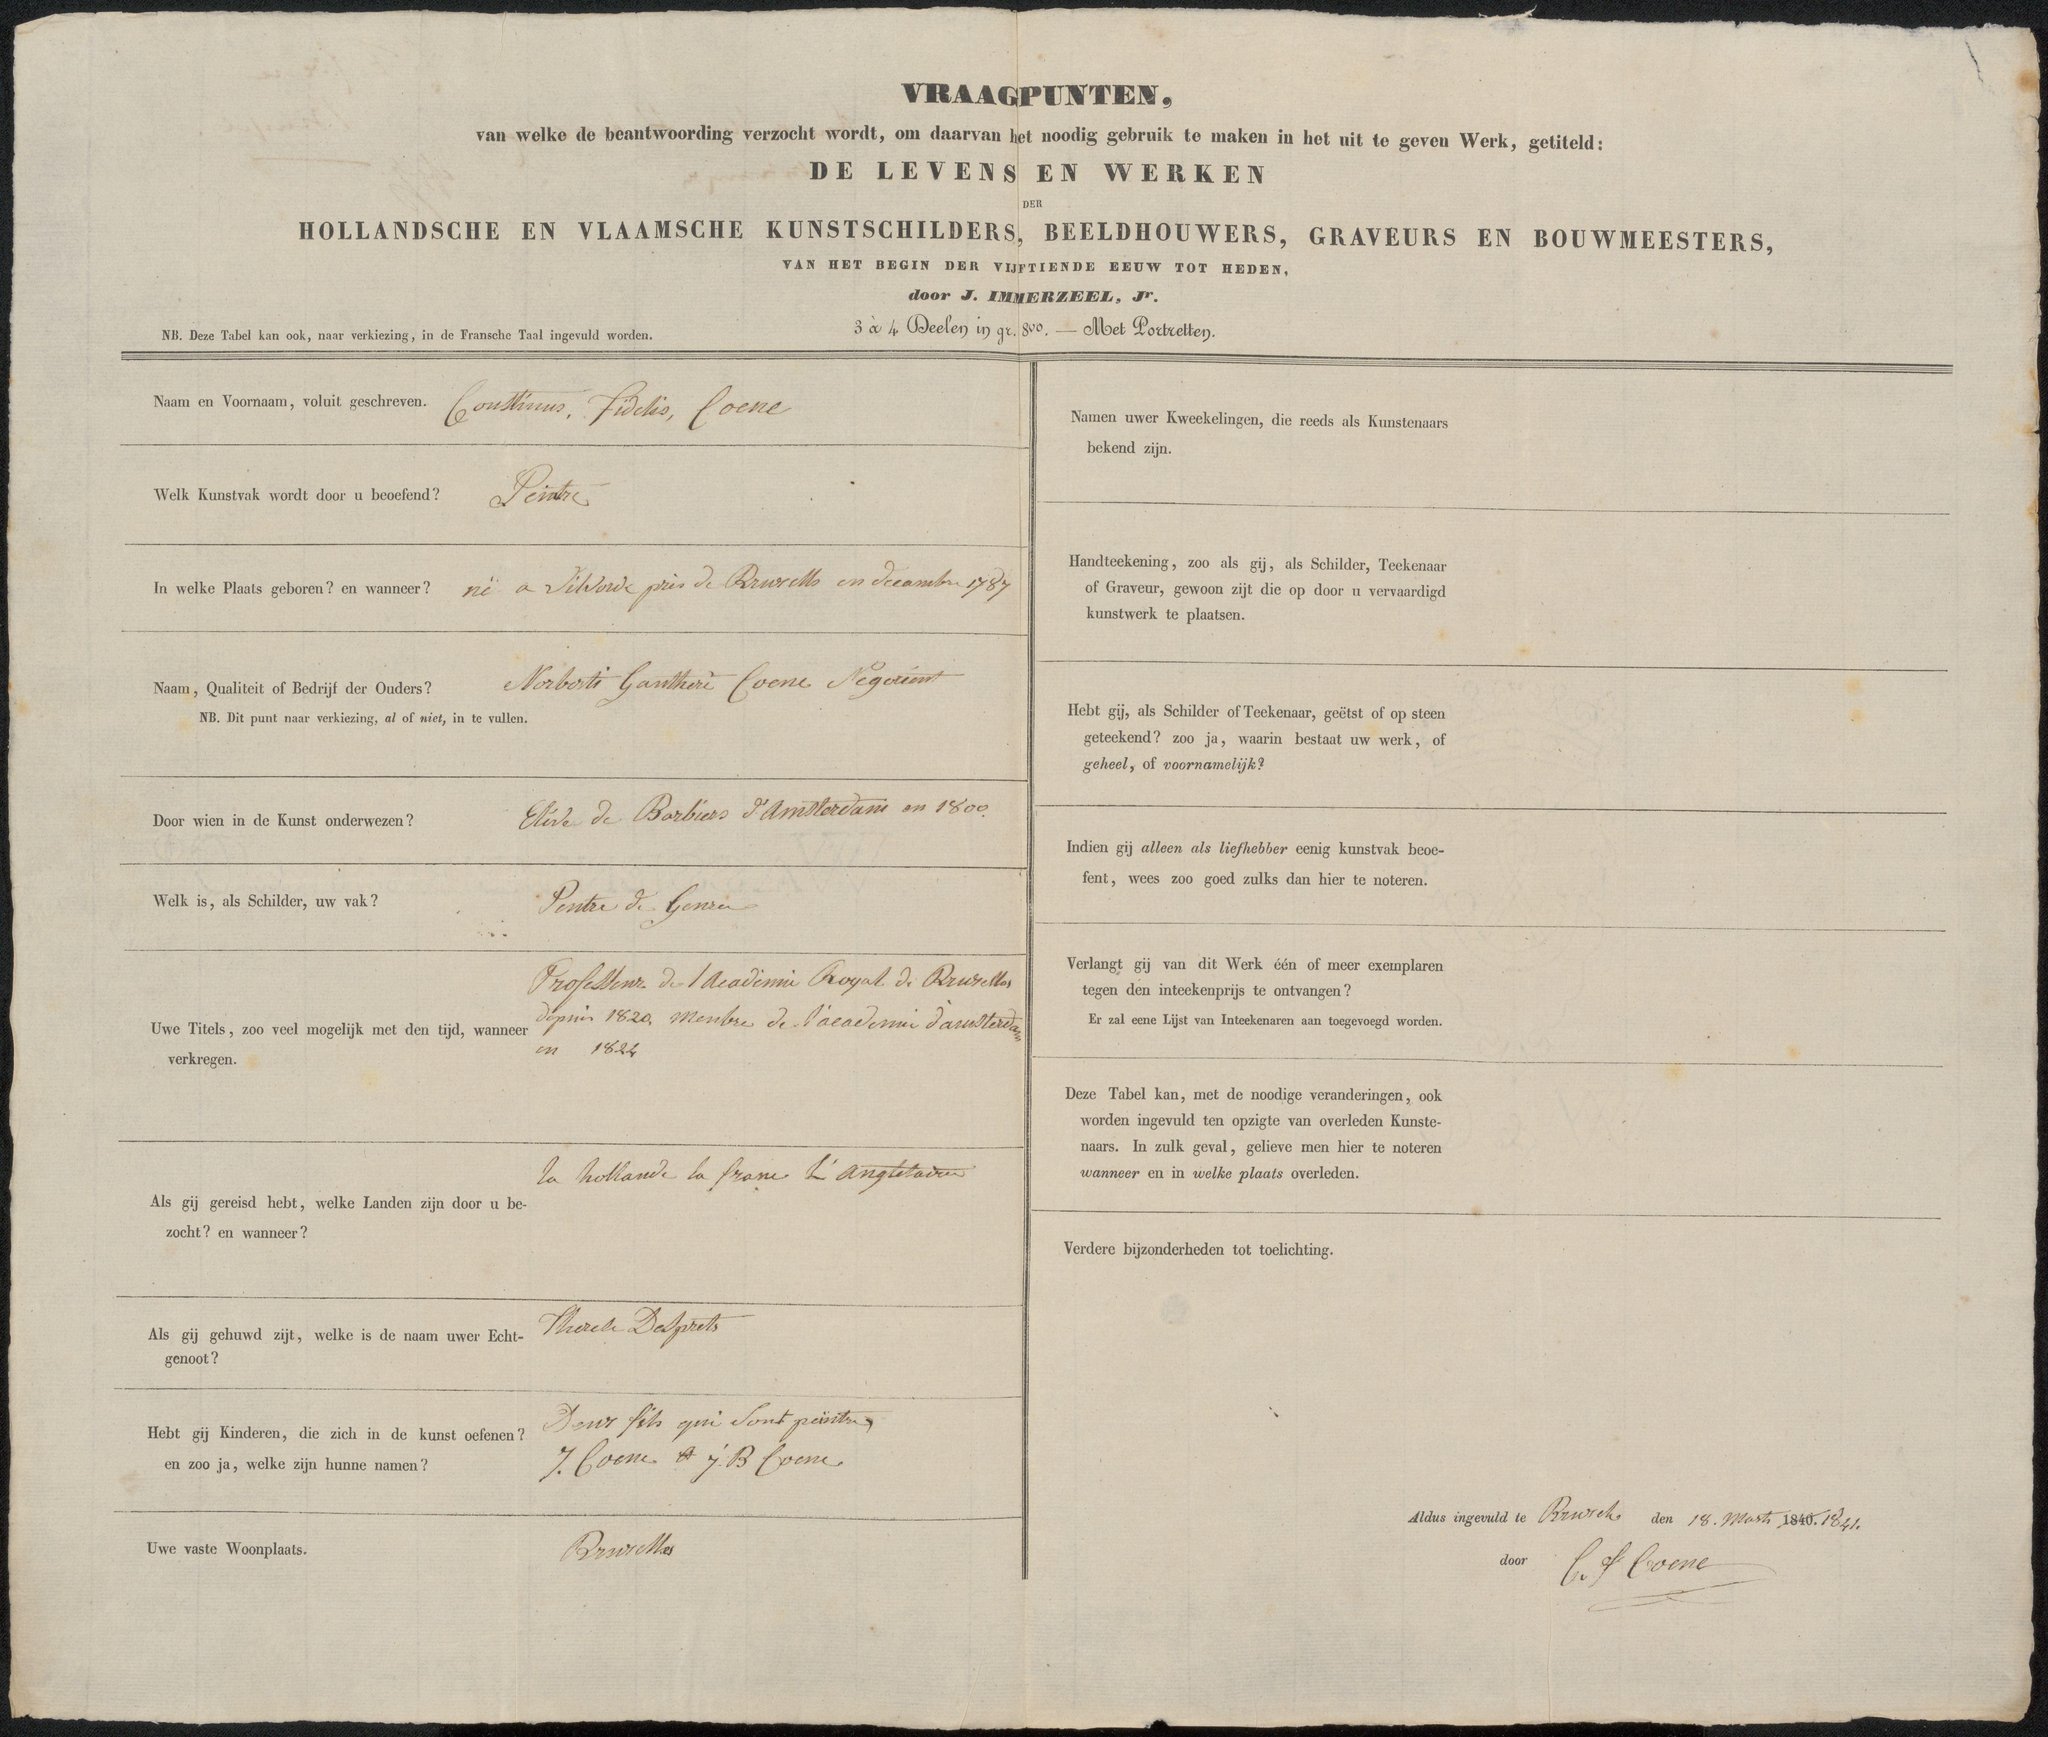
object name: questionnaire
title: Enquêteformulier ingevuld door Constantinus Fidelio Coene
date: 1841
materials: ink, paper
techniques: pen, printing, writing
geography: brussels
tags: brussels, painter, draughtsman, constantinus fidelio coene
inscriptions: watermark, inscription: ‘Vraagpunten,/ van welke de beantwoording verzocht wordt, om daarvan het noodig gebruik te maken in het uit te geven Werk, getiteld: De levens en werken/ der Hollandsche en Vlaamsche kunstschilders, beeldhouwers,/ graveurs en bouwmeesters, van het begin der vijftiende eeuw tot heden/ door J. Immerzeel, Jr.’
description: Opgenomen in: Immerzeel, J. Jr., De levens en werken der Hollandsche en Vlaamsche kunstschilders, beeldhouwers, graveurs en bouwmeesters, van het begin der vijftiende eeuw tot heden, Amsterdam: J.C. van Kesteren, 1842-1843.